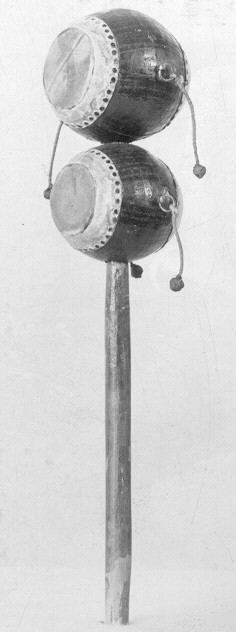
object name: taogu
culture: chinese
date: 1867-1900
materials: cord, wood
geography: china